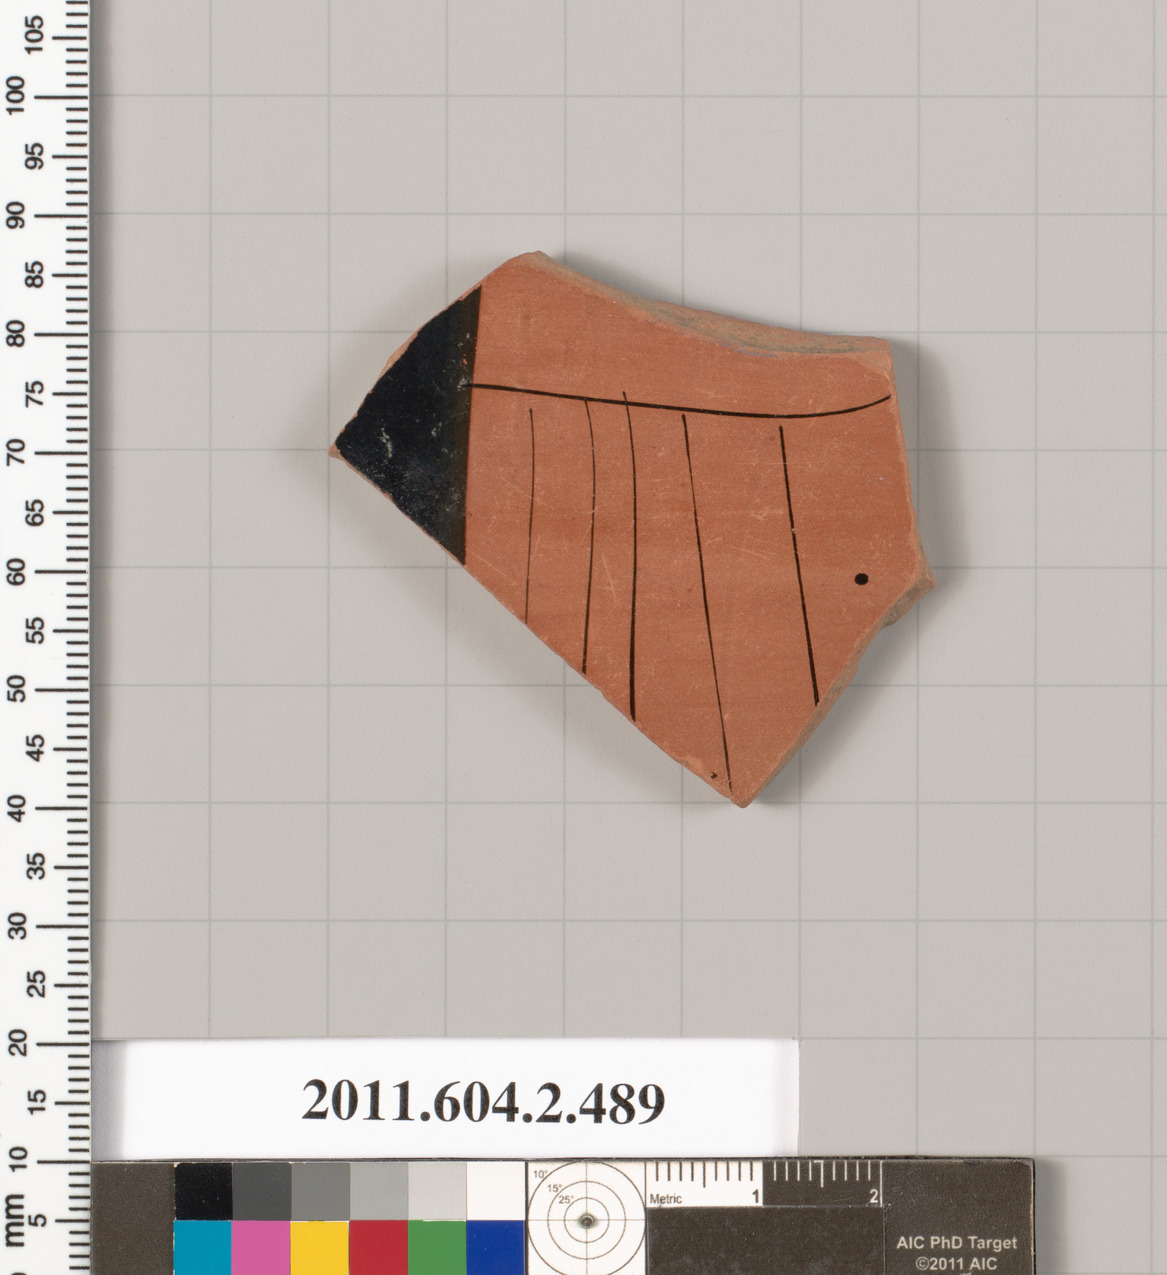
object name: column krater fragment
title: Terracotta fragment of a column-krater? (bowl for mixing wine and water)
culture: greek, attic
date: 440-420 BCE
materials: terracotta